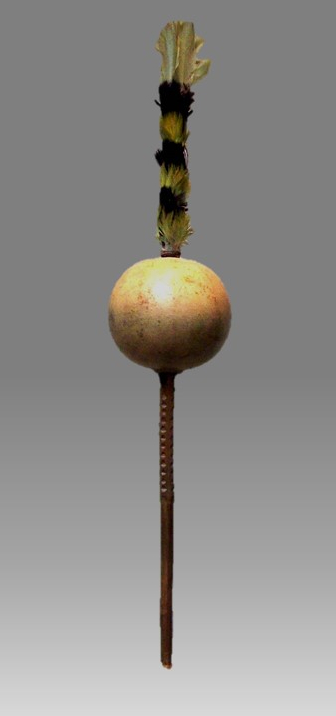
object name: shak shak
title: Shak-Shak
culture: native american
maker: atorios people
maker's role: culture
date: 1801-1900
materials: cord, feather, wood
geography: guyana